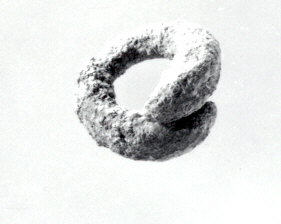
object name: spiral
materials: silver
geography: syria